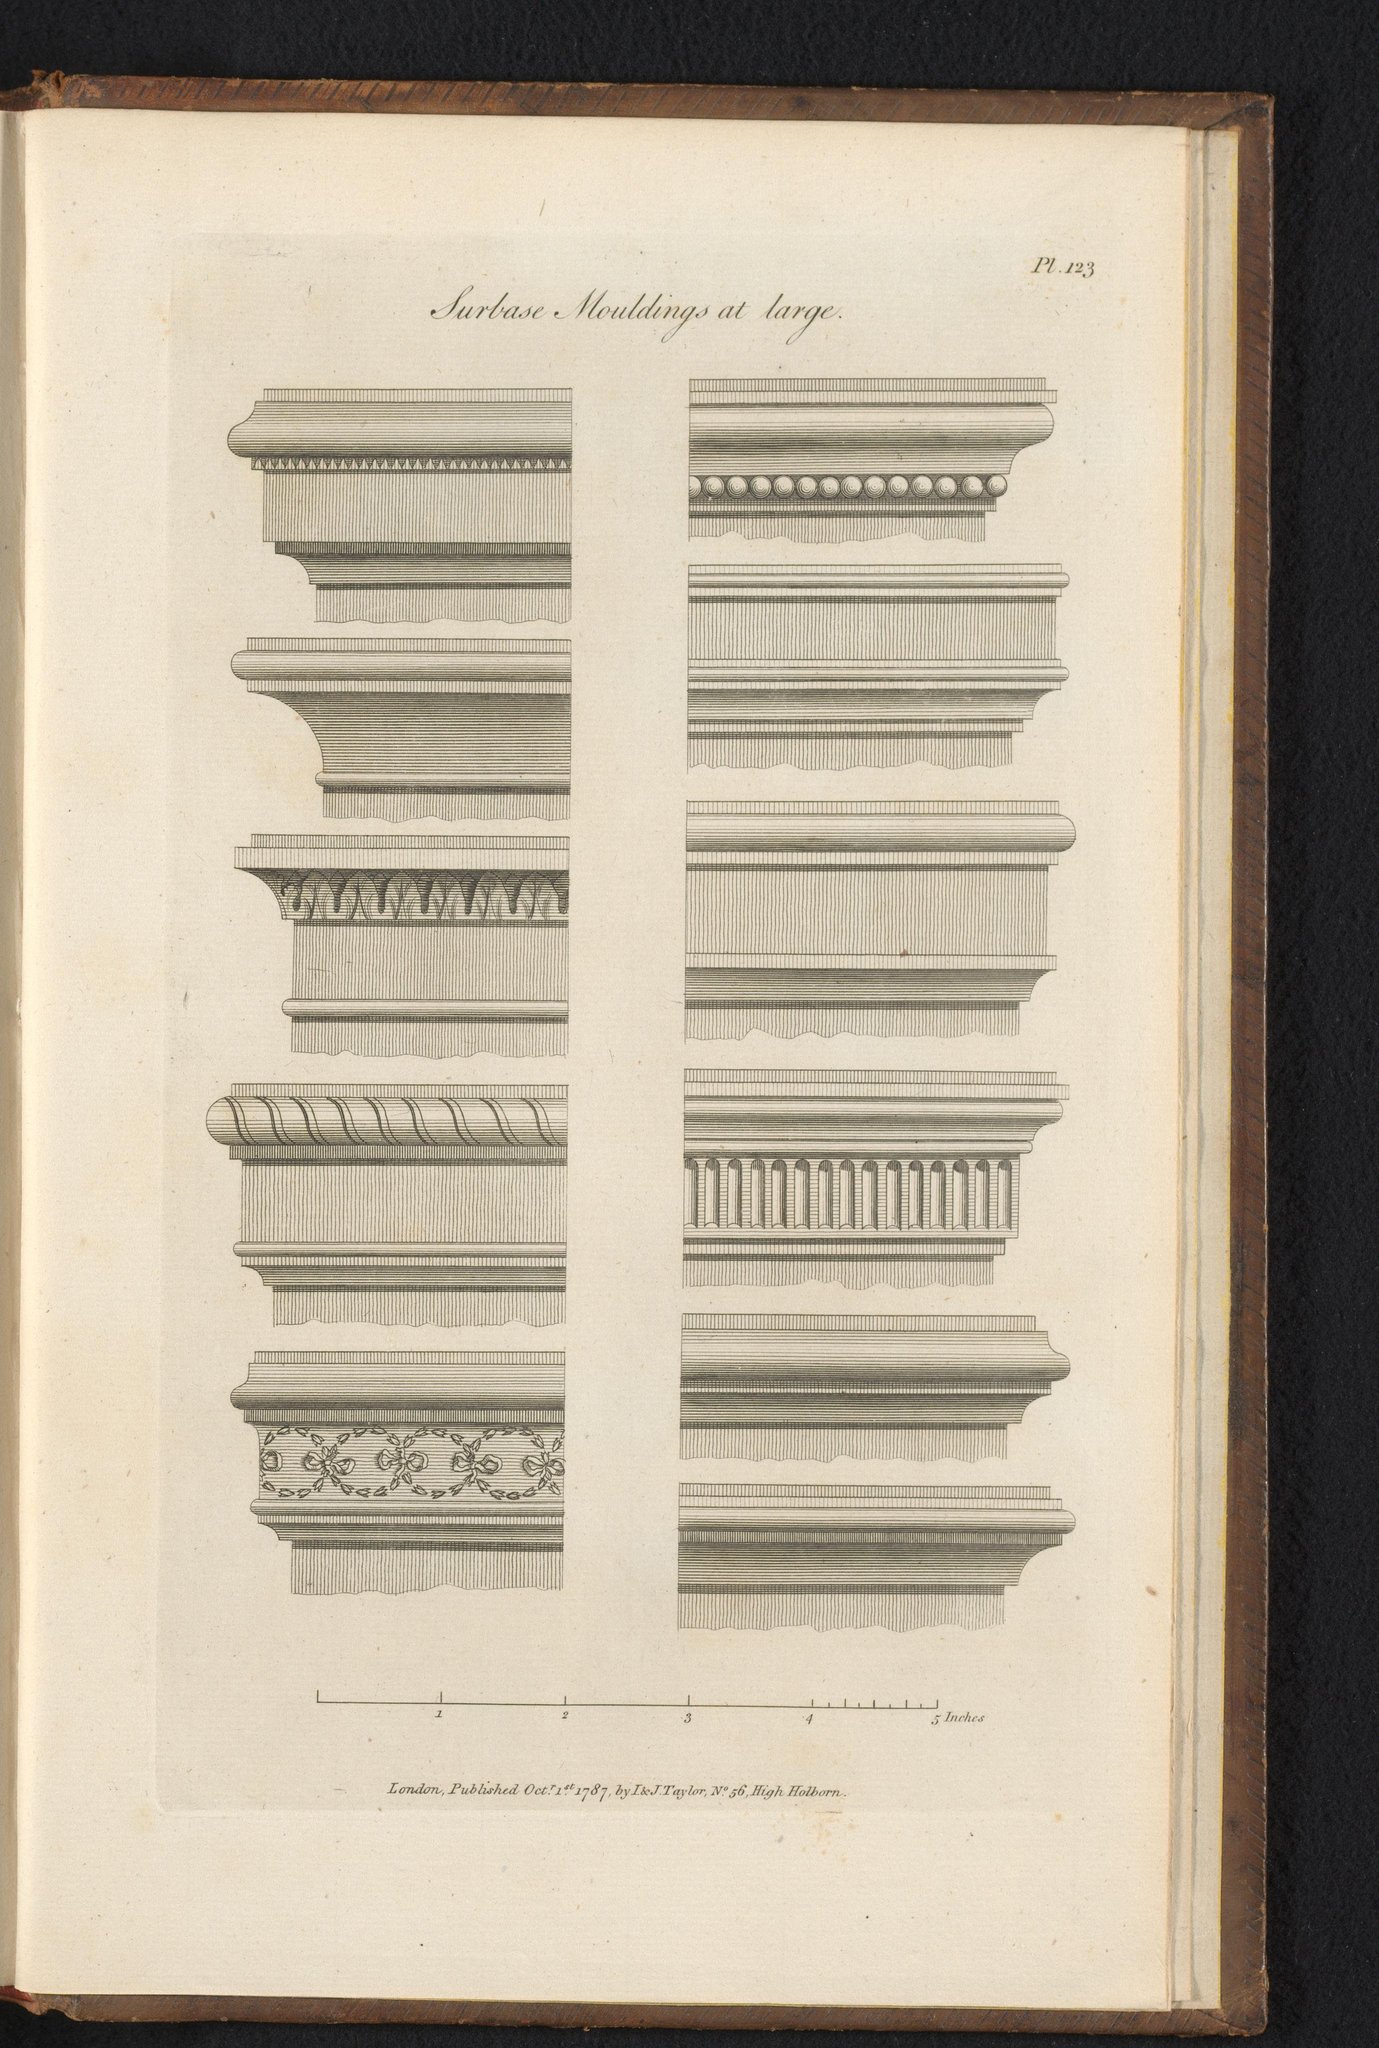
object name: print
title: Elf kroonlijsten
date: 1787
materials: paper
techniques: engraving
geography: holborn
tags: other architectural details: architrave, other architectural details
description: Genummerd: Pl. 123. Schaalverdeling in de ondermarge. Prent maakt deel uit van een boek.